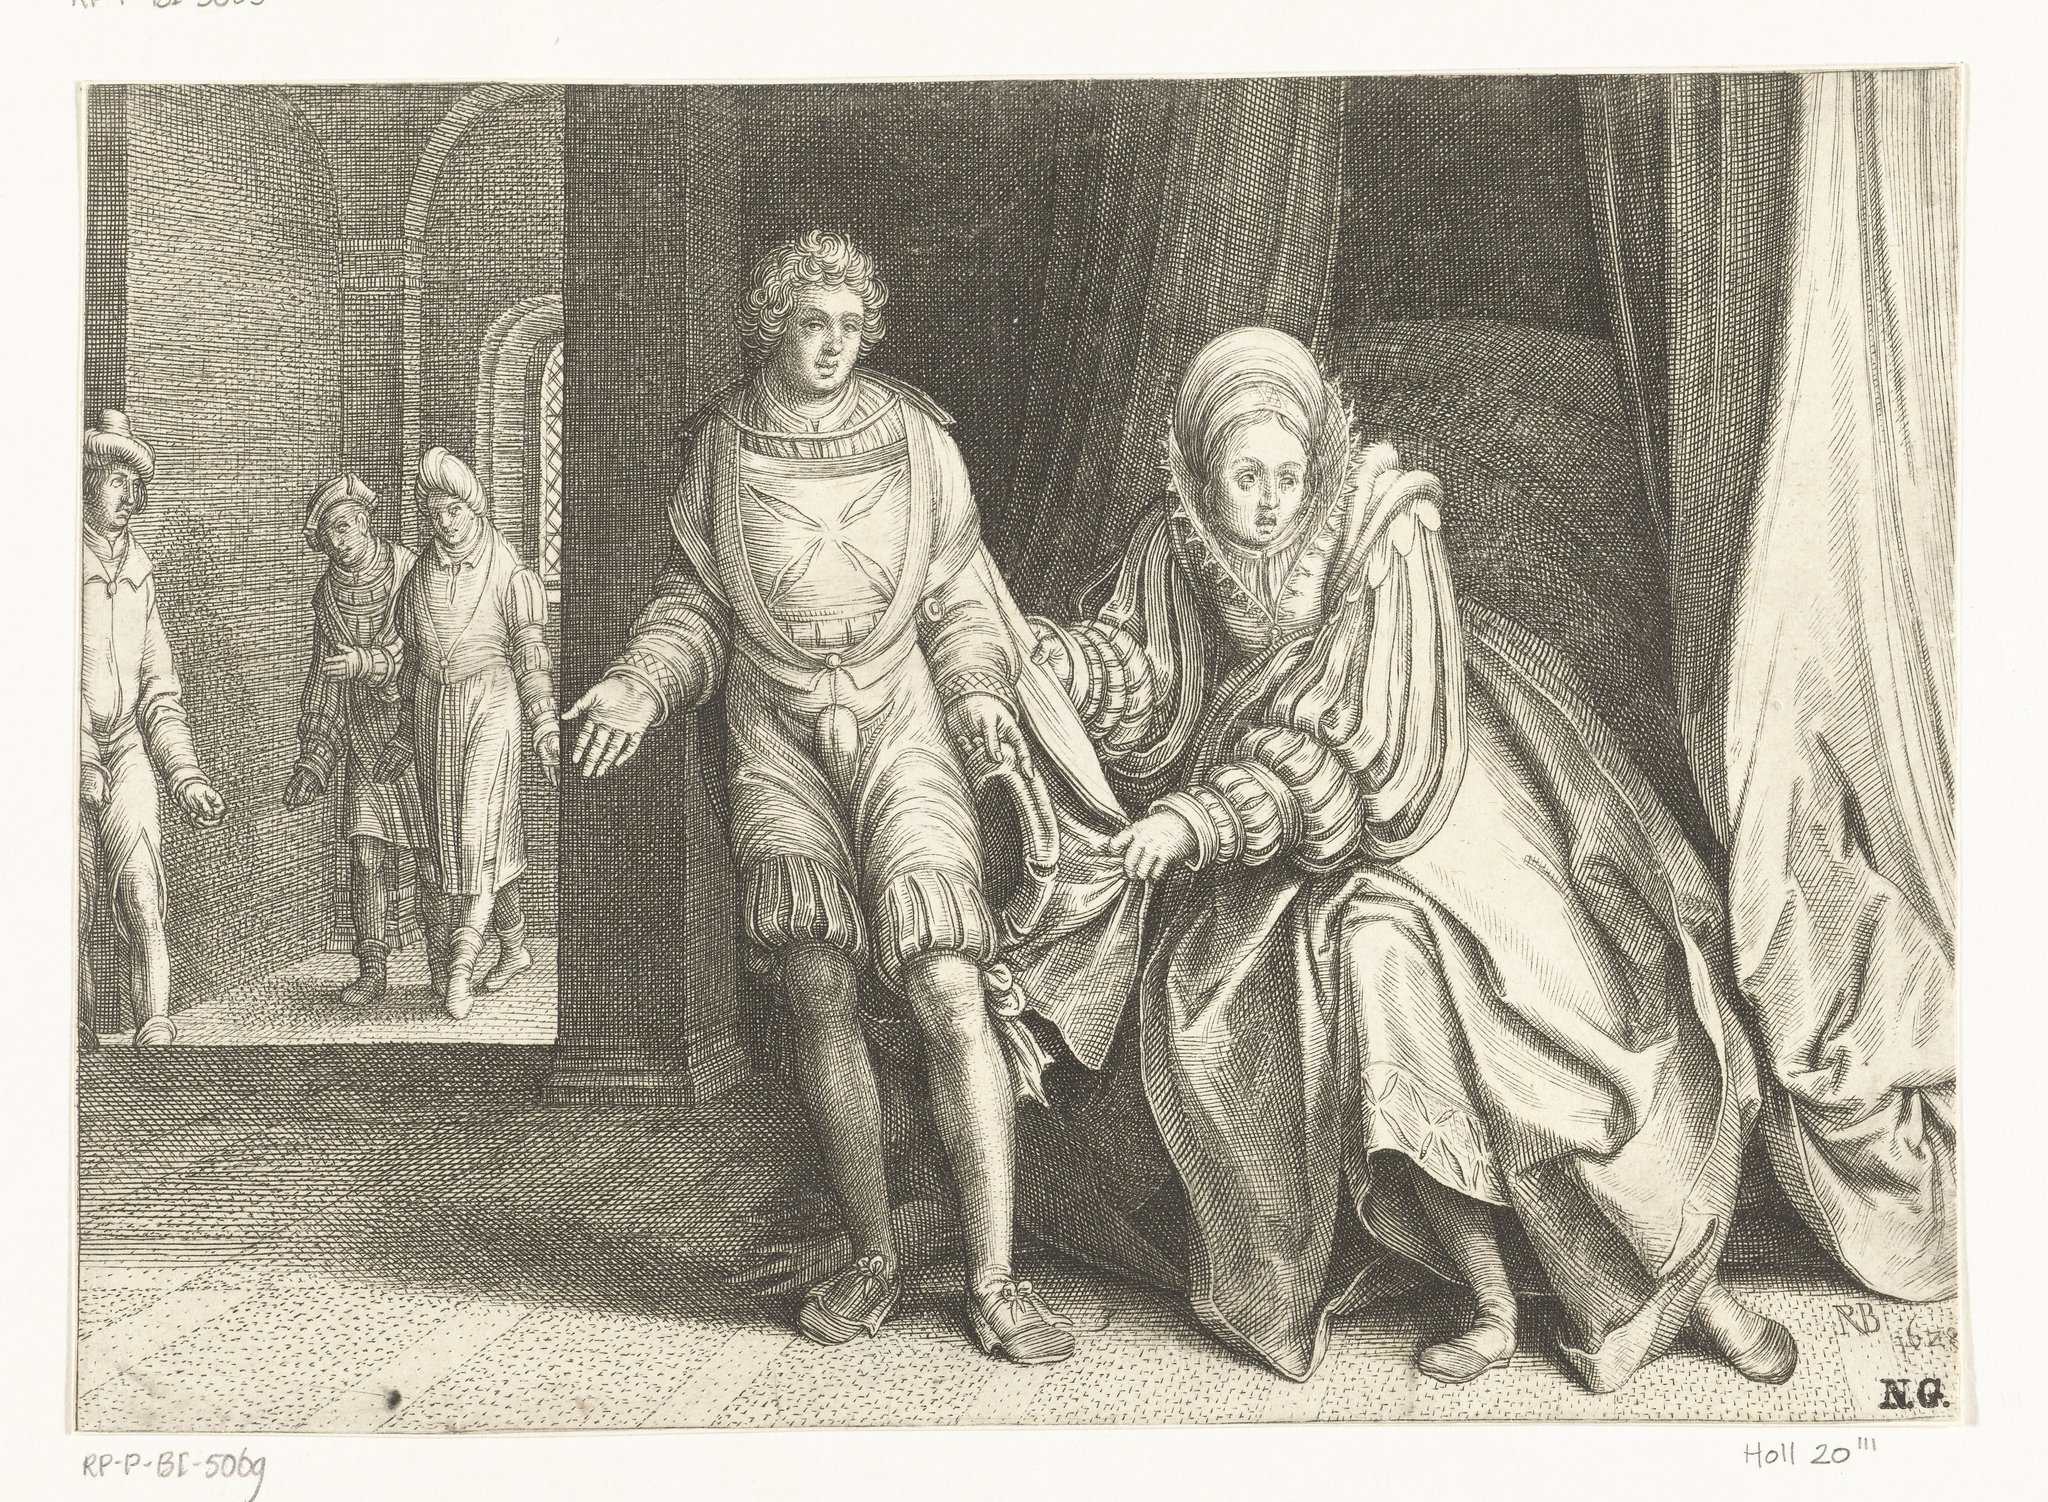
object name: print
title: Verhaal van Jozef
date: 1628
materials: paper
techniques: engraving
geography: netherlands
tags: potiphar's wife trying to seduce joseph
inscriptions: collector's mark: Lugt 2228, collector's mark: Lugt 1967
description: Prent uit serie van zes prenten met het verhaal van Jozef. De serie is geïnspireerd op een vergelijkbare reeks van Lucas van Leyden.